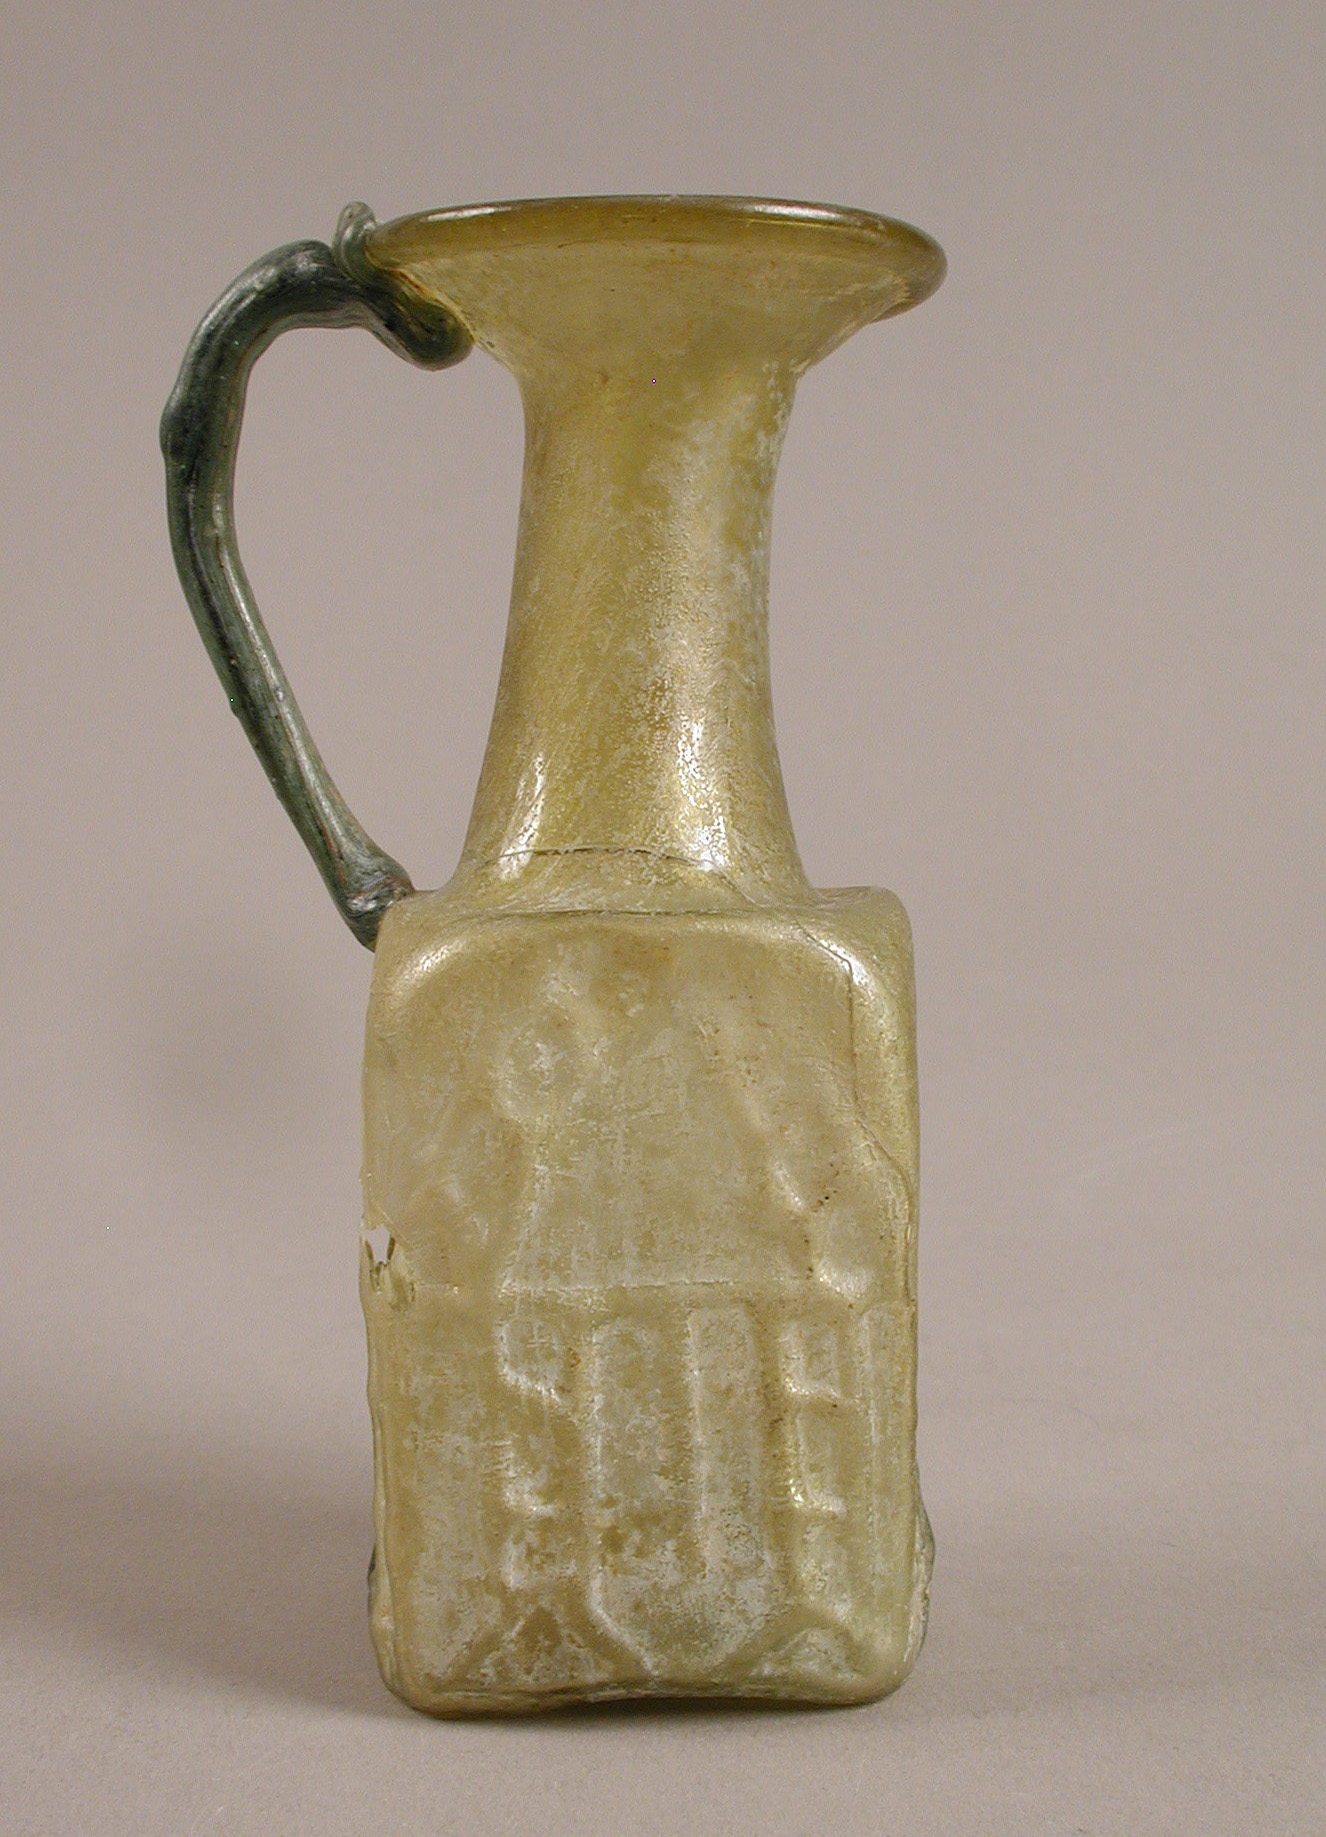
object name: jug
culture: syrian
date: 501-700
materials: glass